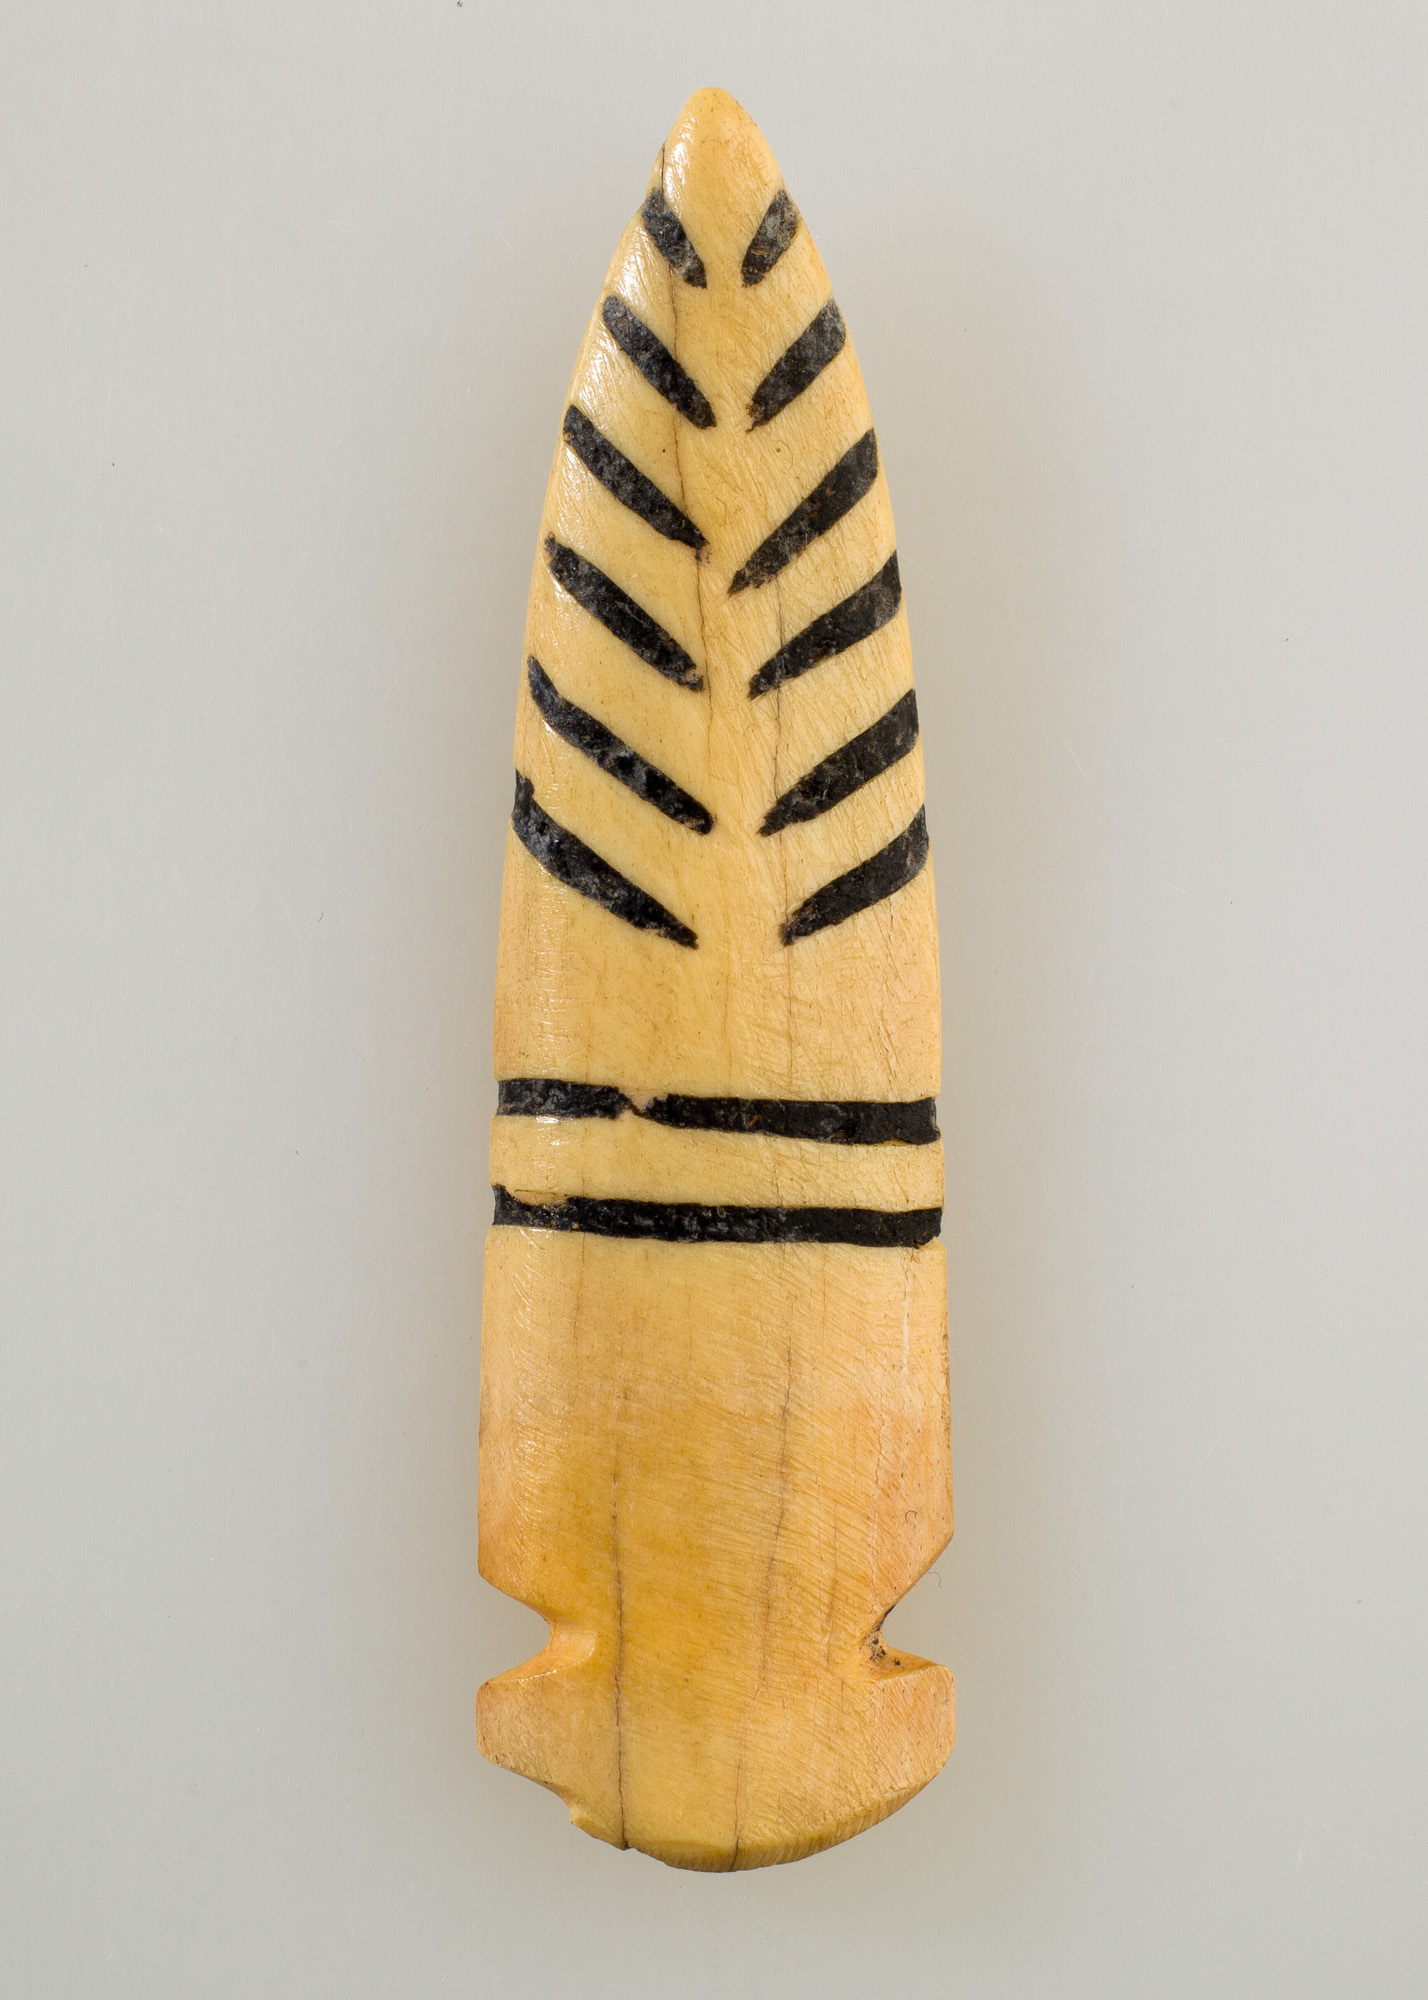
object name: amulet, tusk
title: Tusk amulet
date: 3900-3500 BCE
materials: bone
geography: egypt